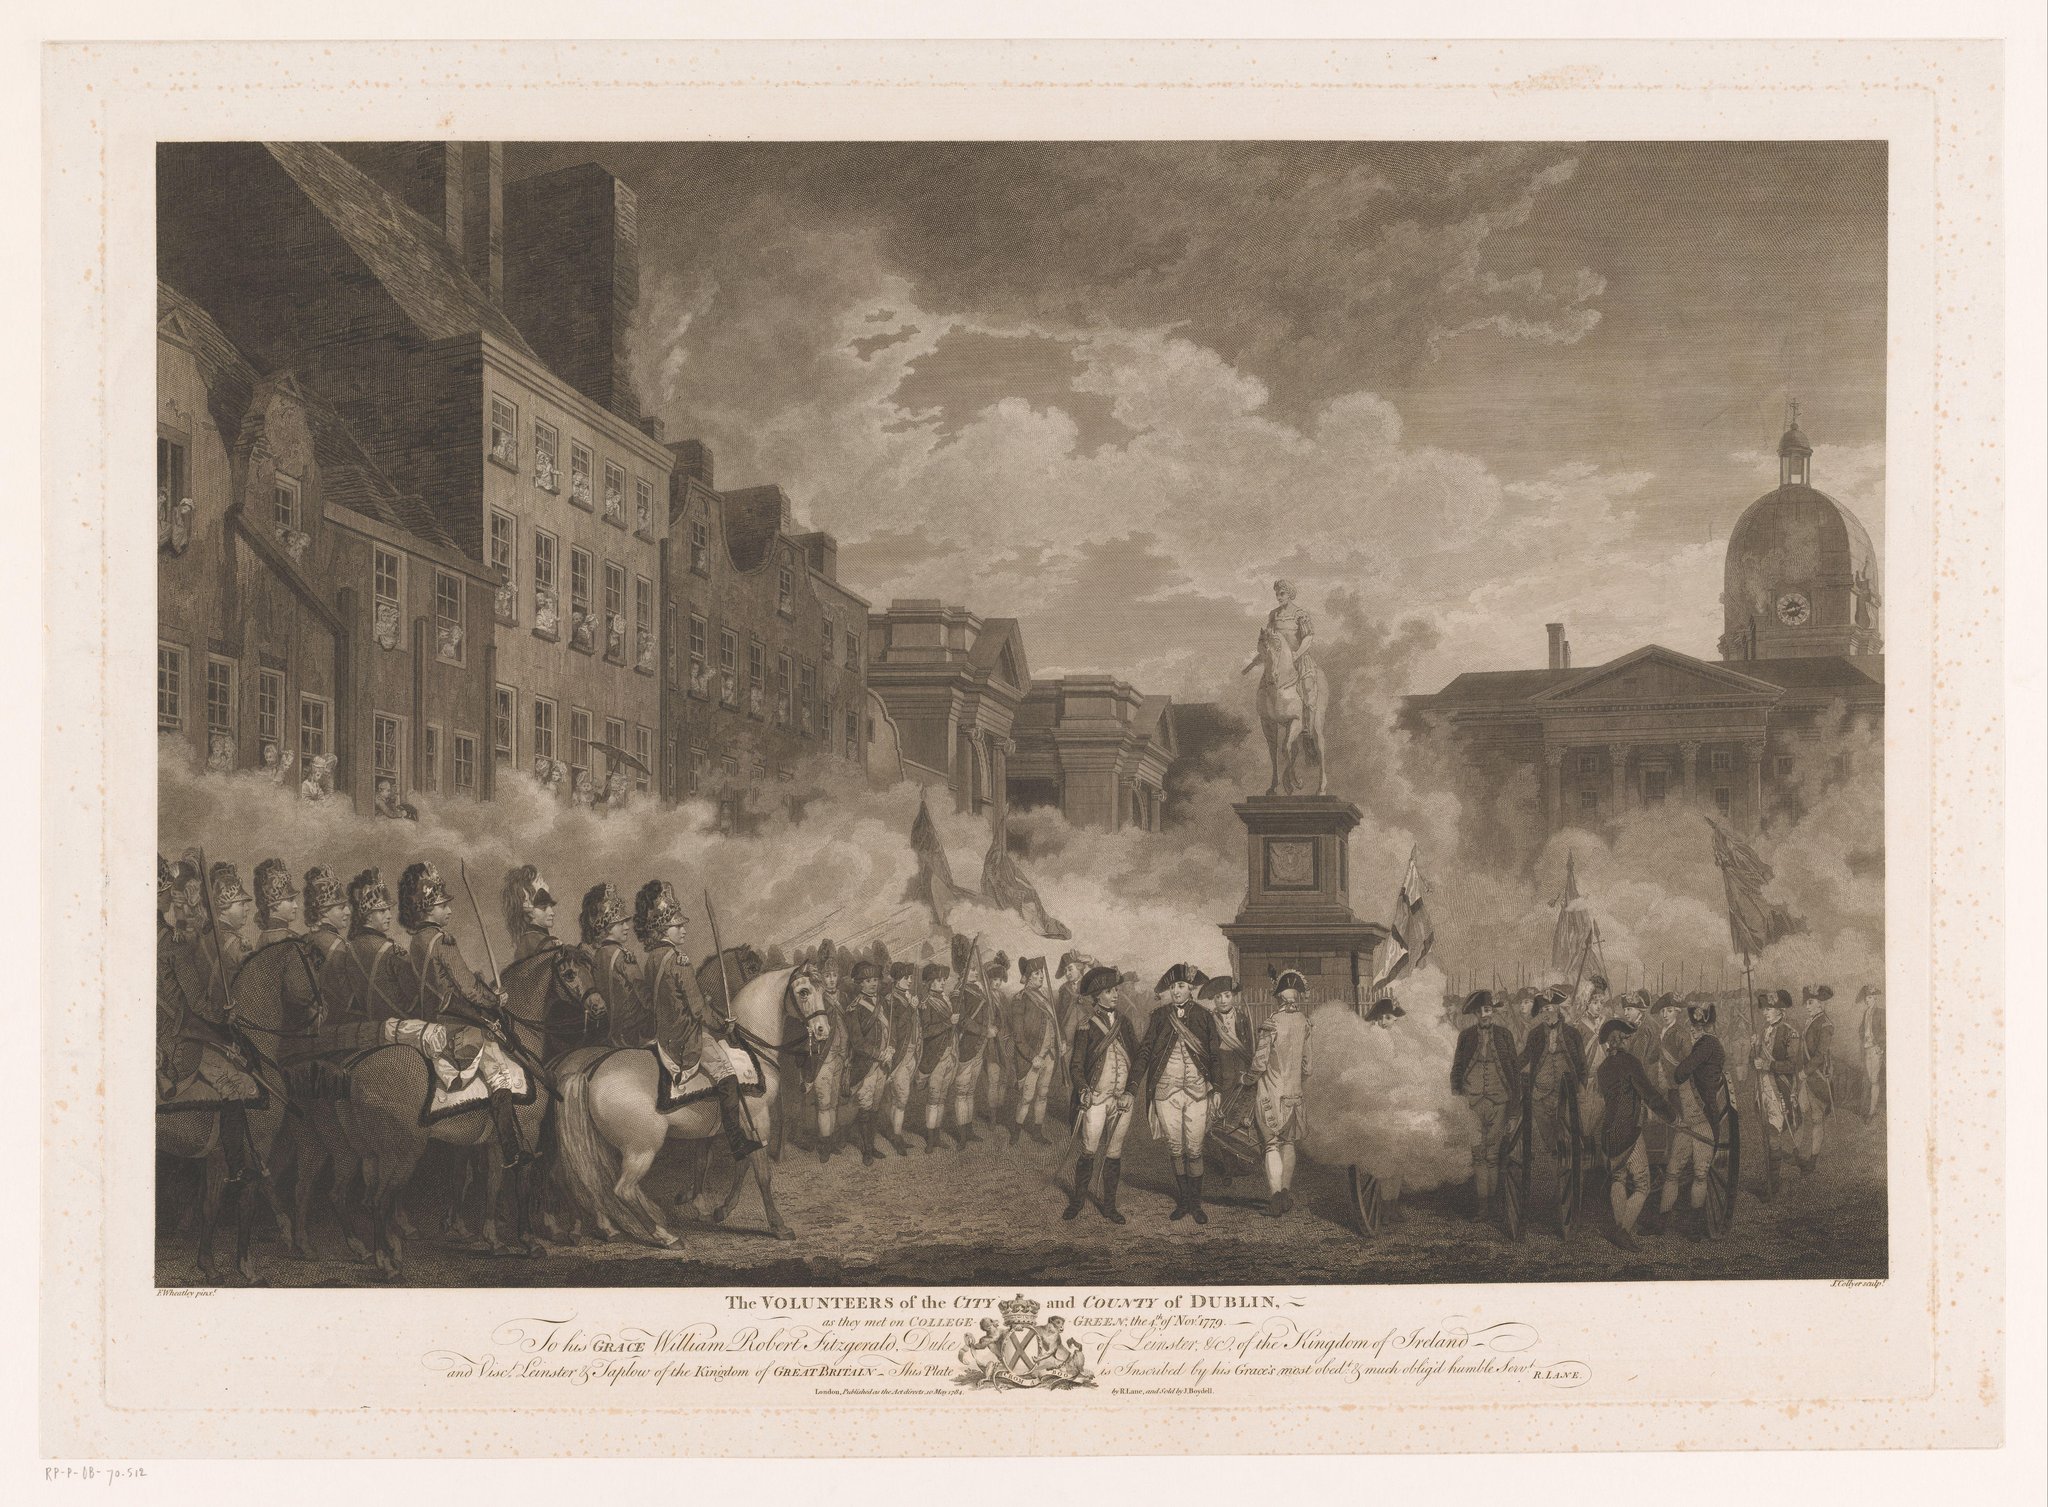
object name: print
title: The Volunteers of the City and County of Dublin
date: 1711-1784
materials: paper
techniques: engraving, etching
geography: london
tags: square, place, circus, etc., military parade, pageant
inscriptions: collector's mark: Lugt 12